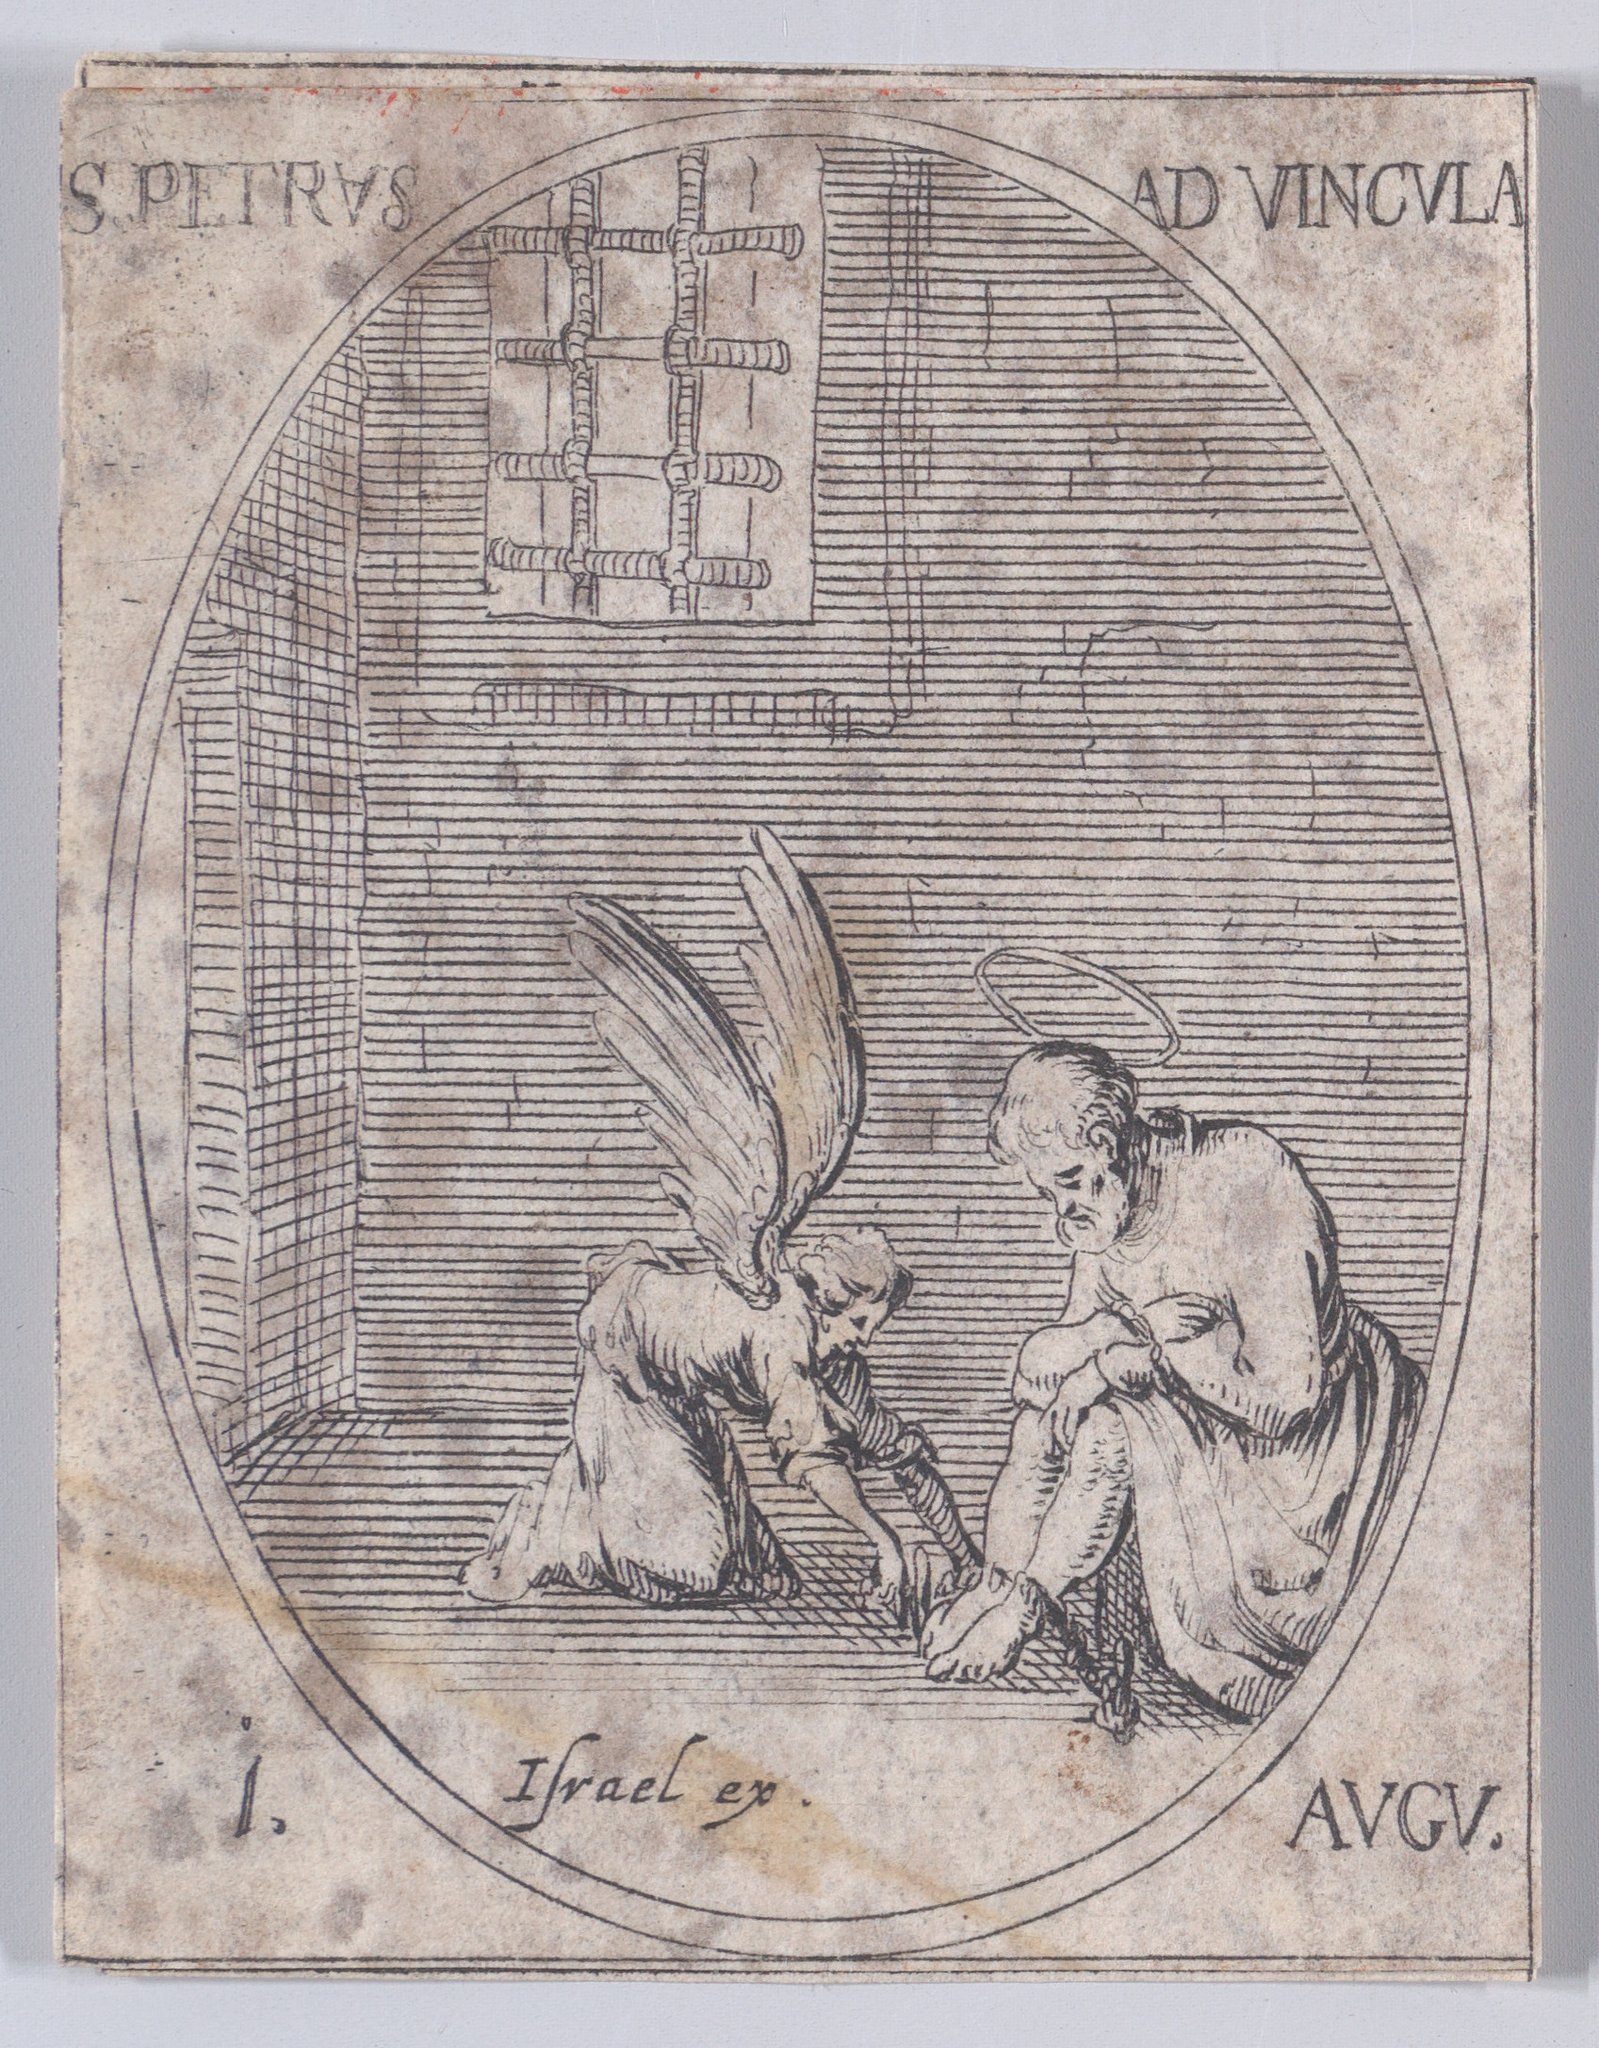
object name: print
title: S. Pierre aux liens (St. Peter in Chains), August 1st, from "Les Images De Tous Les Saincts et Saintes de L'Année" (Images of All of the Saints and Religious Events of the Year)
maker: jacques callot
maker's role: artist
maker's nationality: french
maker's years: 1592-1635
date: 1636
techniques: etching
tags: men,angels,saint peter